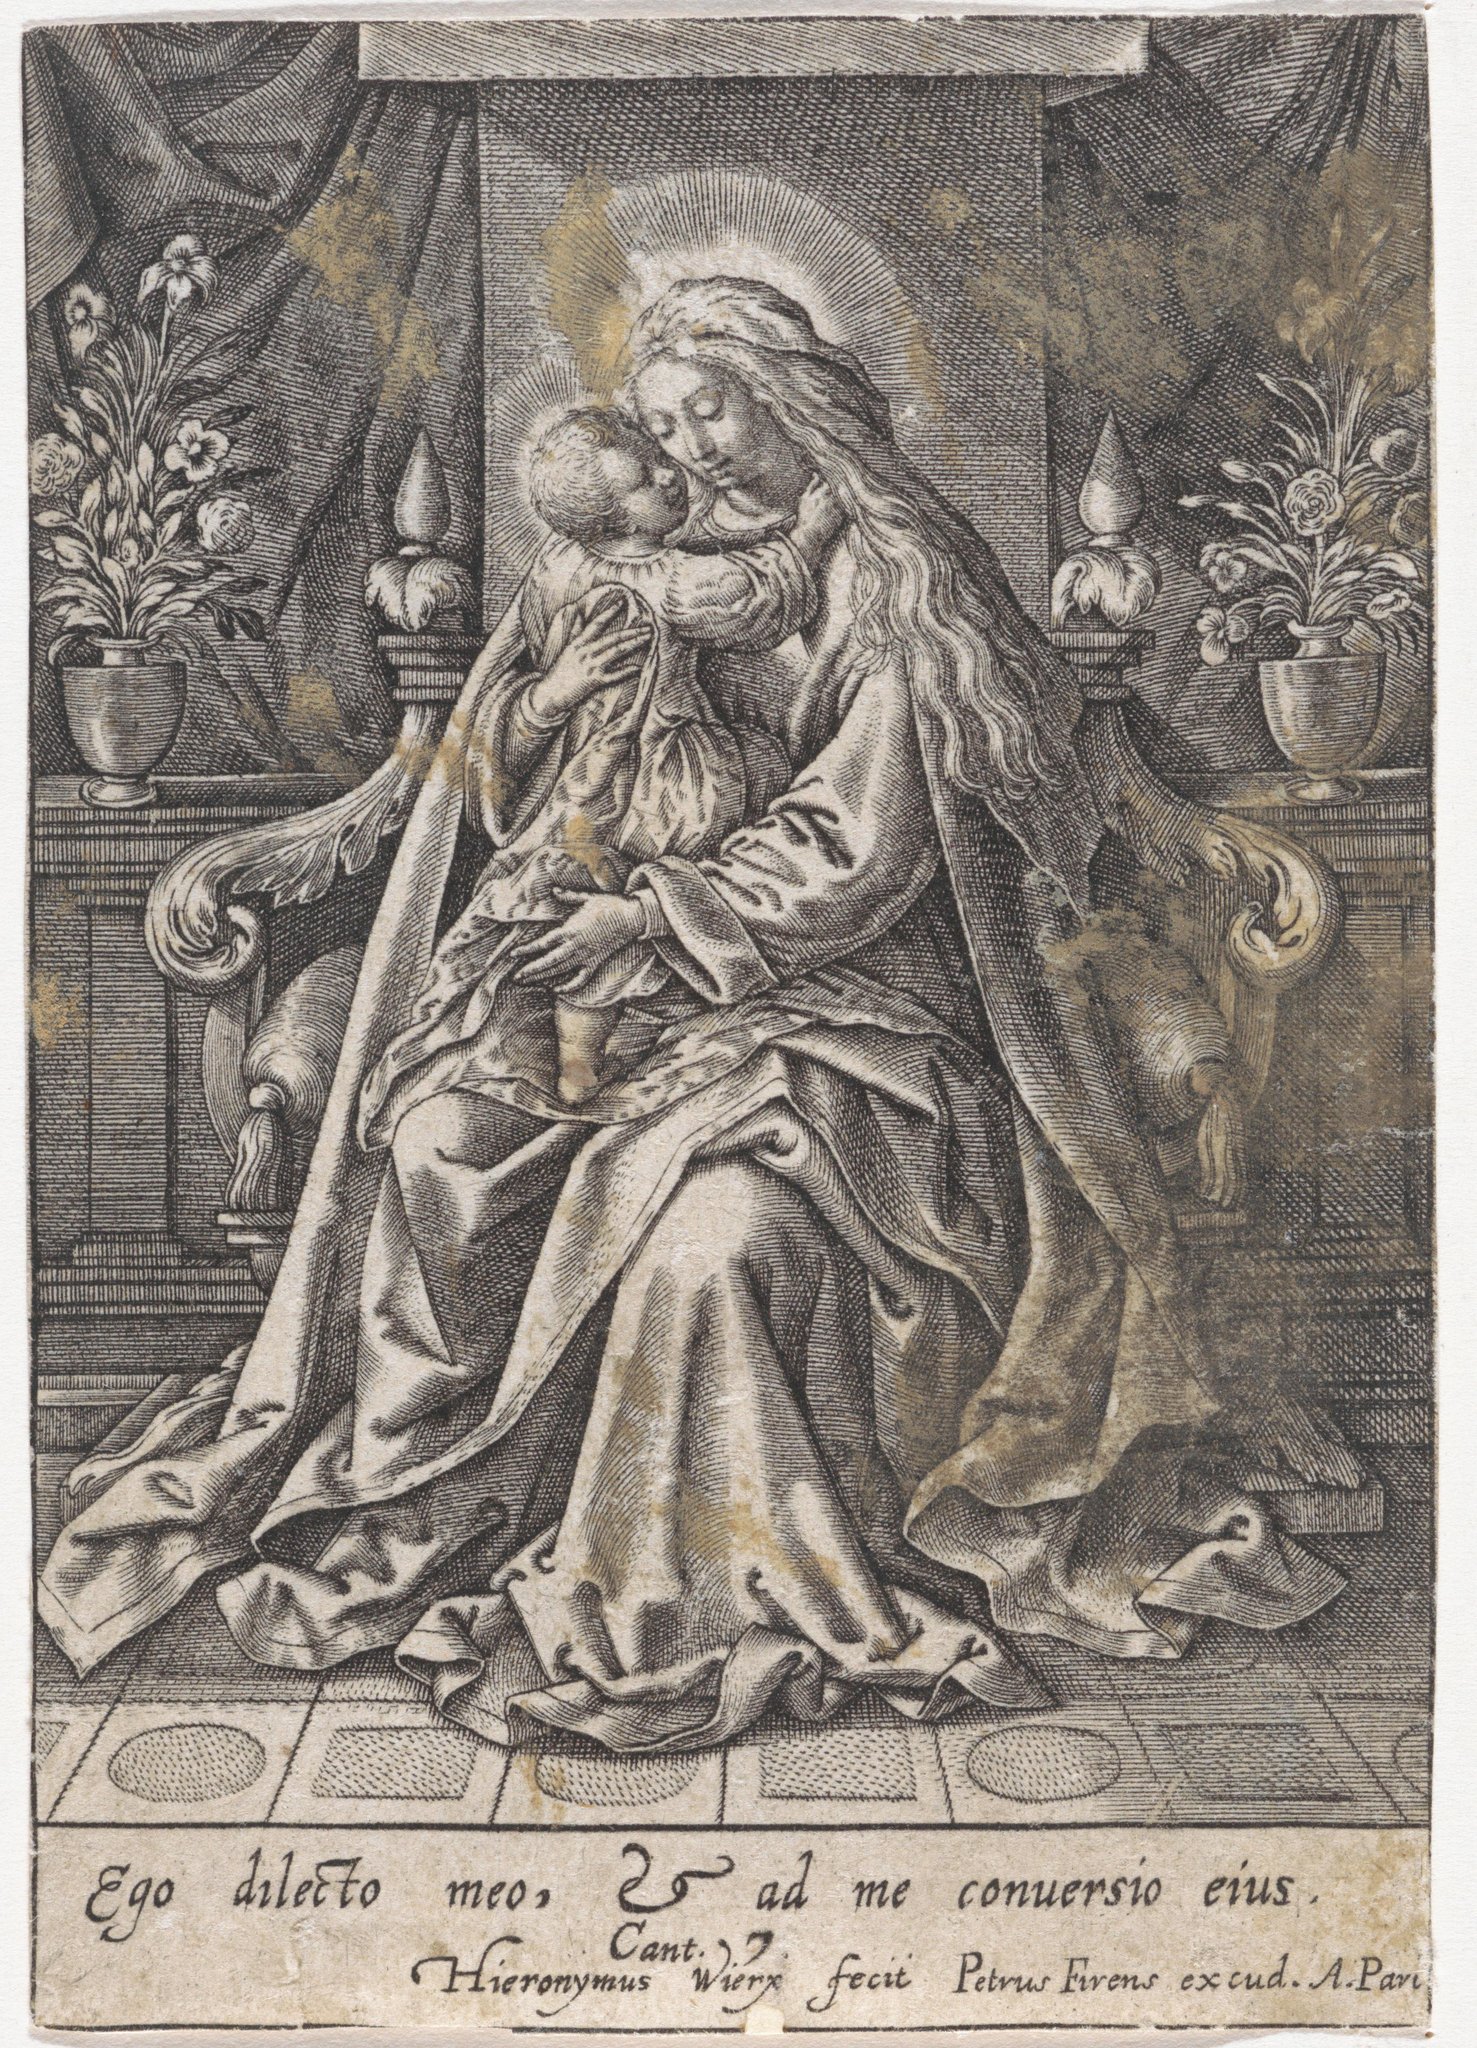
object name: print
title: Maria met Christuskind op een troon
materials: paper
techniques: engraving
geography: antwerp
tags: mary (standing) with the christ-child in front of her (free-standing or leaning against her); christ-child standing - ff - mary sitting or enthroned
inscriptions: collector's mark: Lugt 2228, collector's mark: Lugt 1337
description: Maria zit op een troon onder een baldakijn, aan weerszijden vazen met bloemen. Ze omhelst het Christuskind dat op haar schoot staat. In de marge een Bijbelcitaat uit Hoogl. 7 in het Latijn.